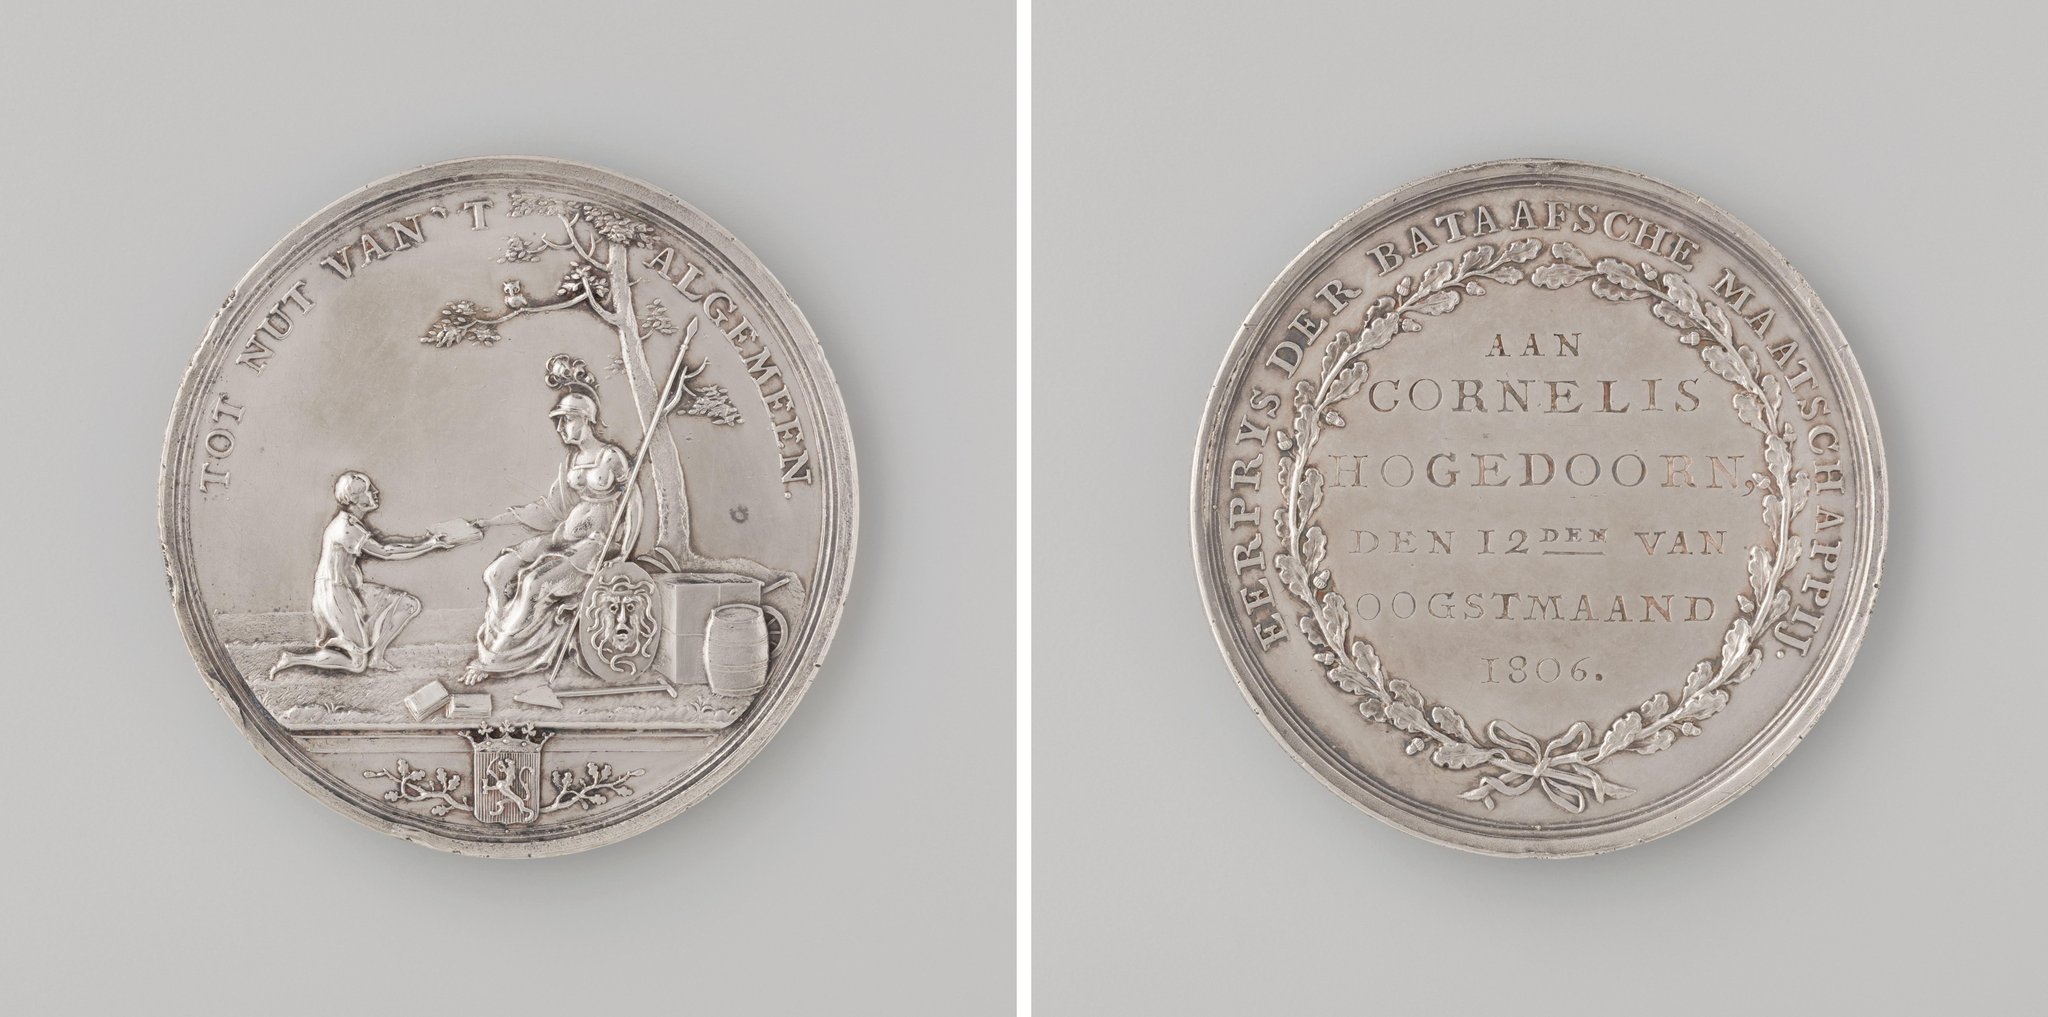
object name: medal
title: Bataafsche Maatschappij tot Nut van 't Algemeen, penning uitgereikt aan Cornelis Hogendoorn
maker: johan george holtzhey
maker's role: mintmaster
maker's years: 1726-1808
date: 1798-1806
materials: silver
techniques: engraving, striking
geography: amsterdam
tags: maatschappij tot nut van 't algemeen, cornelis hogedoorn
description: Bataafsche Maatschappij tot Nut van 't Algemeen